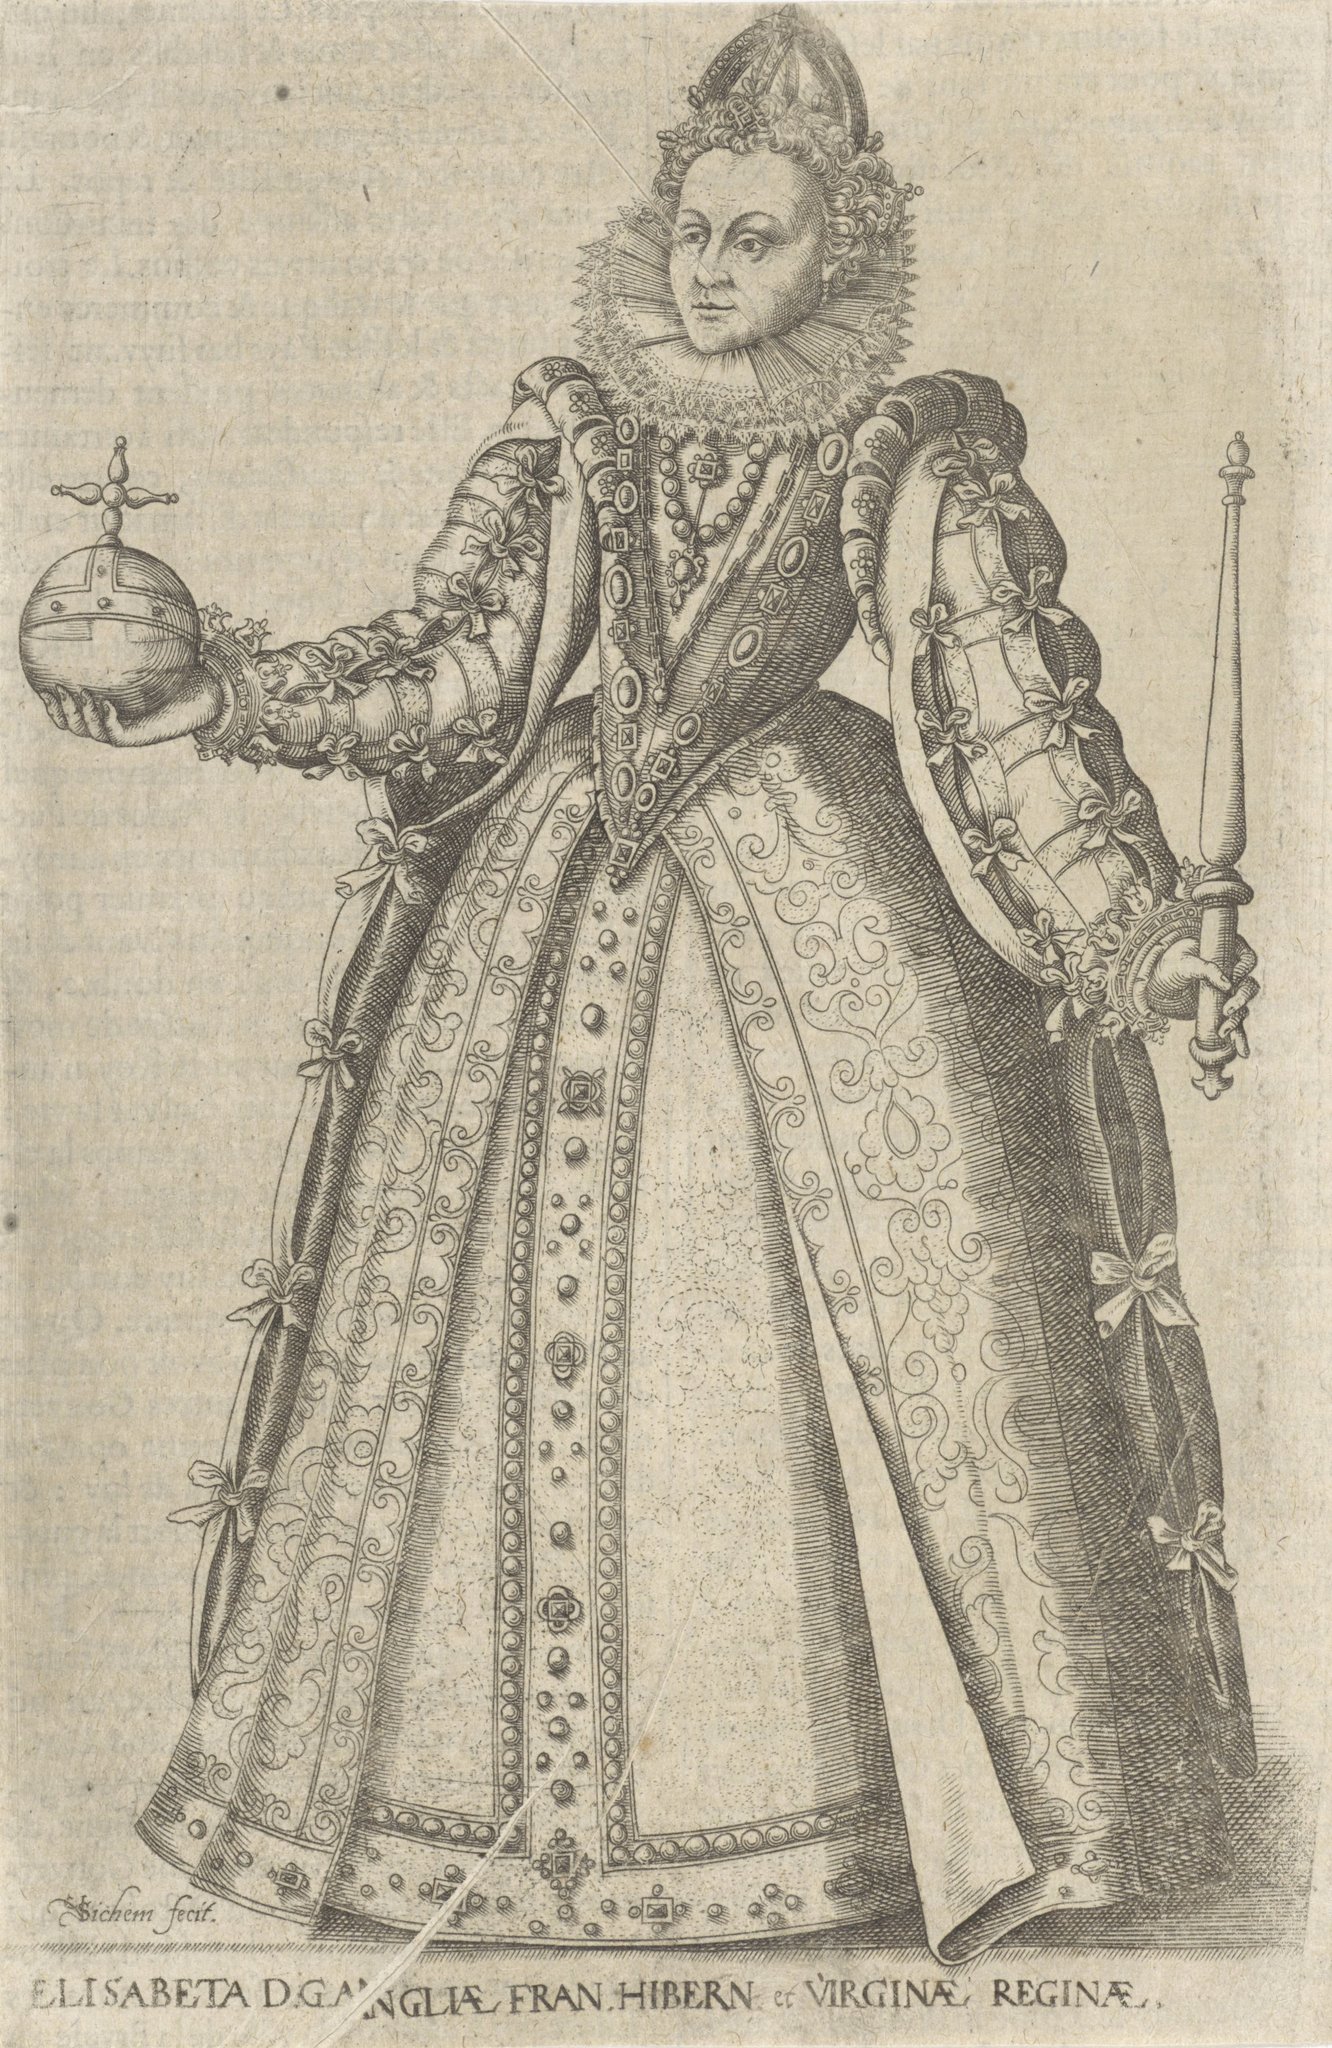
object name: print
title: Elisabeta D G Angliae Fran. Hibern. et Virginae Reginae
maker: christoffel van sichem (i)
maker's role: print maker, publisher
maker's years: 1546-1624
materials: paper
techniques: engraving, etching, letterpress printing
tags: sceptre, staff (symbol of sovereignty) - bb - female ruler, orb (symbol of sovereignty; sphere with cross on top) - bb - female ruler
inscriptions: collector's mark: Lugt 2228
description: Prent komt voor in: Jean François Le Petit. La grande chroniqve ancienne et moderne, de Hollande, Zelande, VVestfrise, Vtrecht, Frise, Overyssel & Groeningen. 2 vols. Dordrecht: J. Canin en G. Guillemot, 1601.